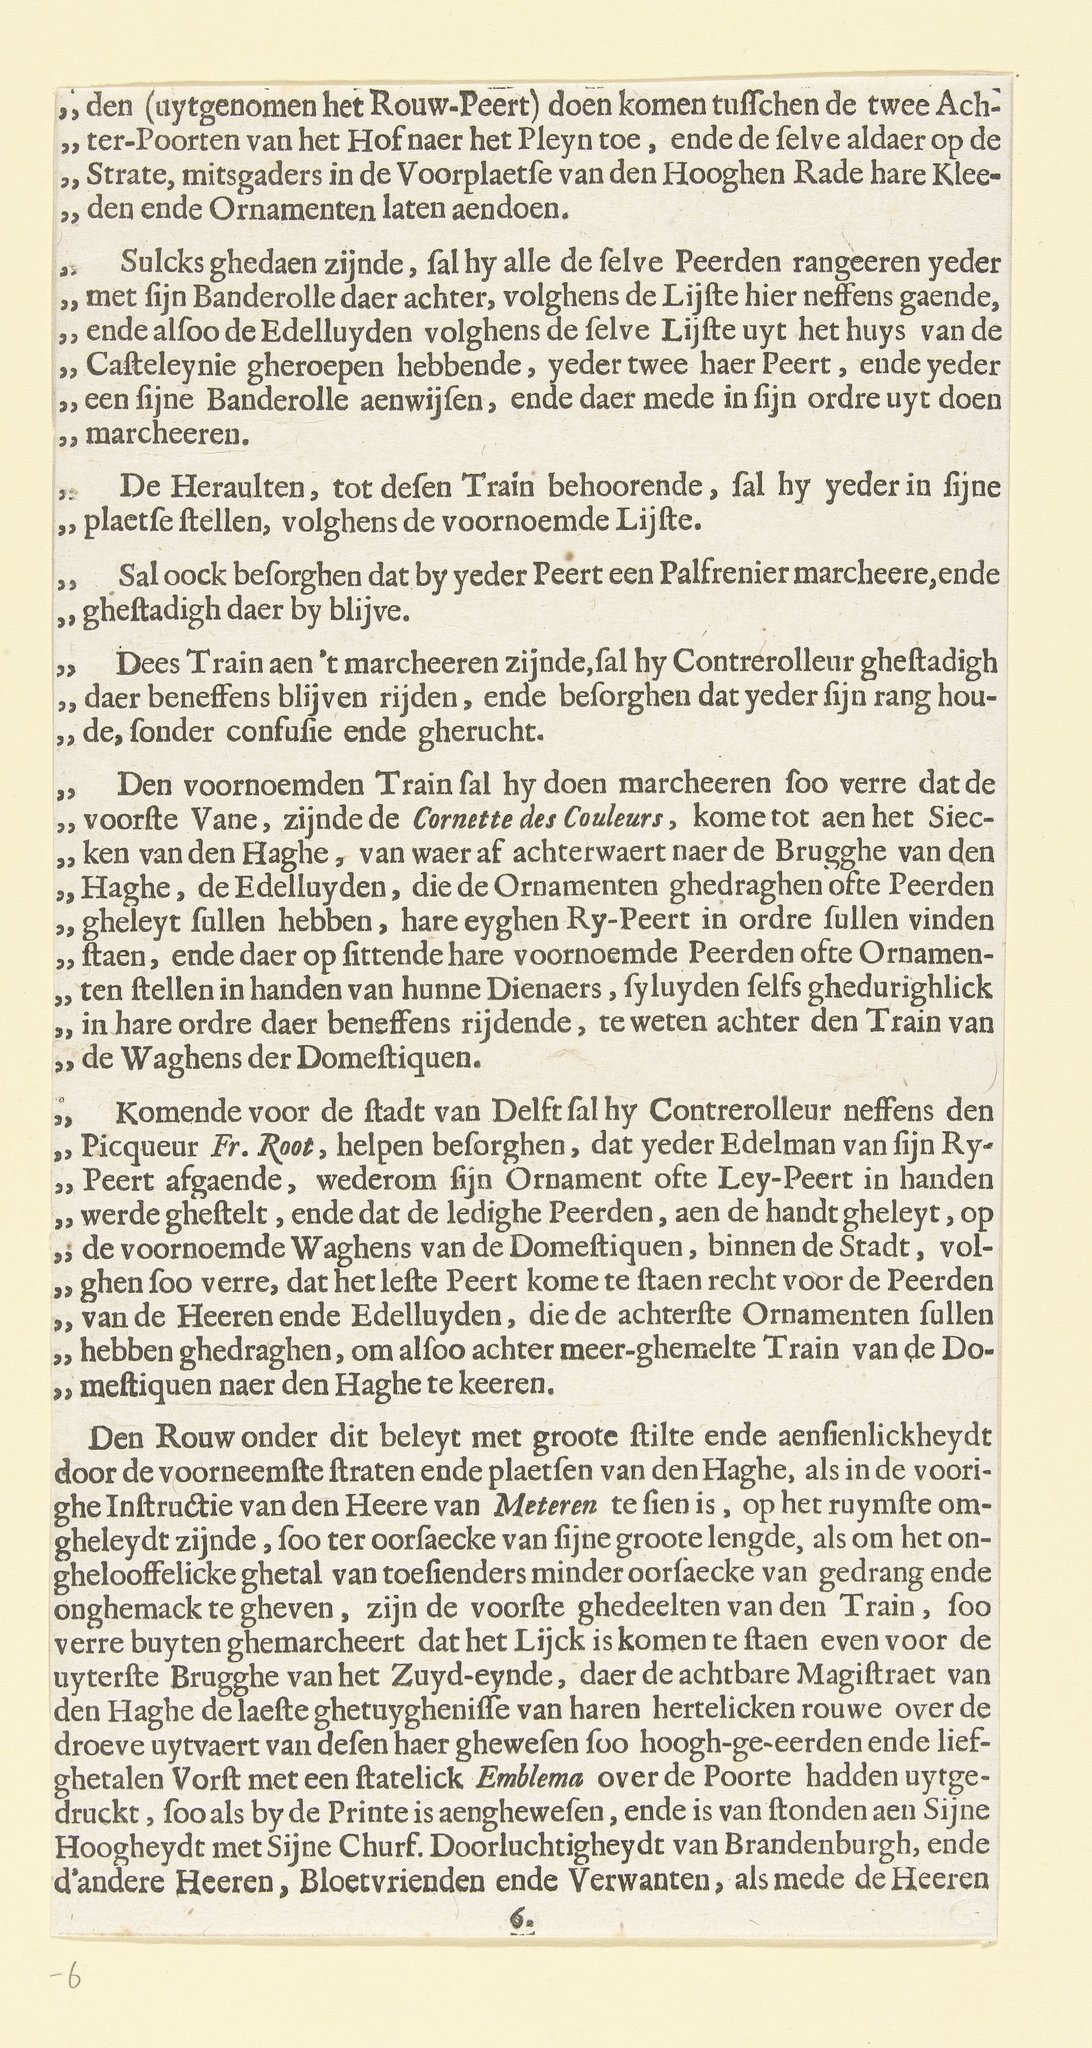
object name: text sheet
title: De begrafenisstoet van Frederik Hendrik (tekstblad 6), 1647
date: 1651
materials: paper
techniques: letterpress printing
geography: the hague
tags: delft, frederick henry (prince of orange), the hague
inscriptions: collector's mark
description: Tekstblad nr. 6 bij de prentserie van de begrafenisstoet van stadhouder Frederik Hendrik te 's-Gravenhage op 10 mei 1647. Onderdeel van een serie van 30 platen en 20 tekstbladen, bedoeld om aan elkaar geplakt te worden.